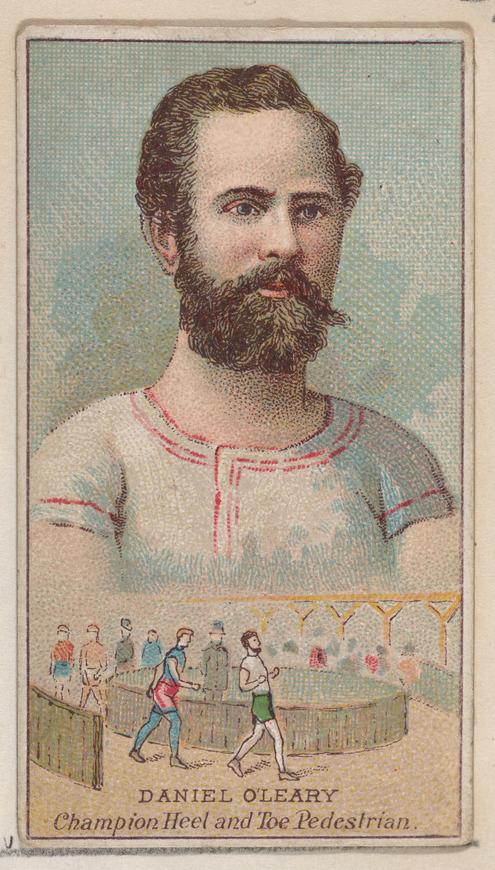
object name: print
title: Daniel O'Leary, Champion Heel and Toe Pedestrian, from the Champions of Games and Sports series (N184, Type 2) issued by W.S. Kimball & Co.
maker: w.s. kimball & co.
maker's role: publisher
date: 1887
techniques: color lithograph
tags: men,sports,athletes